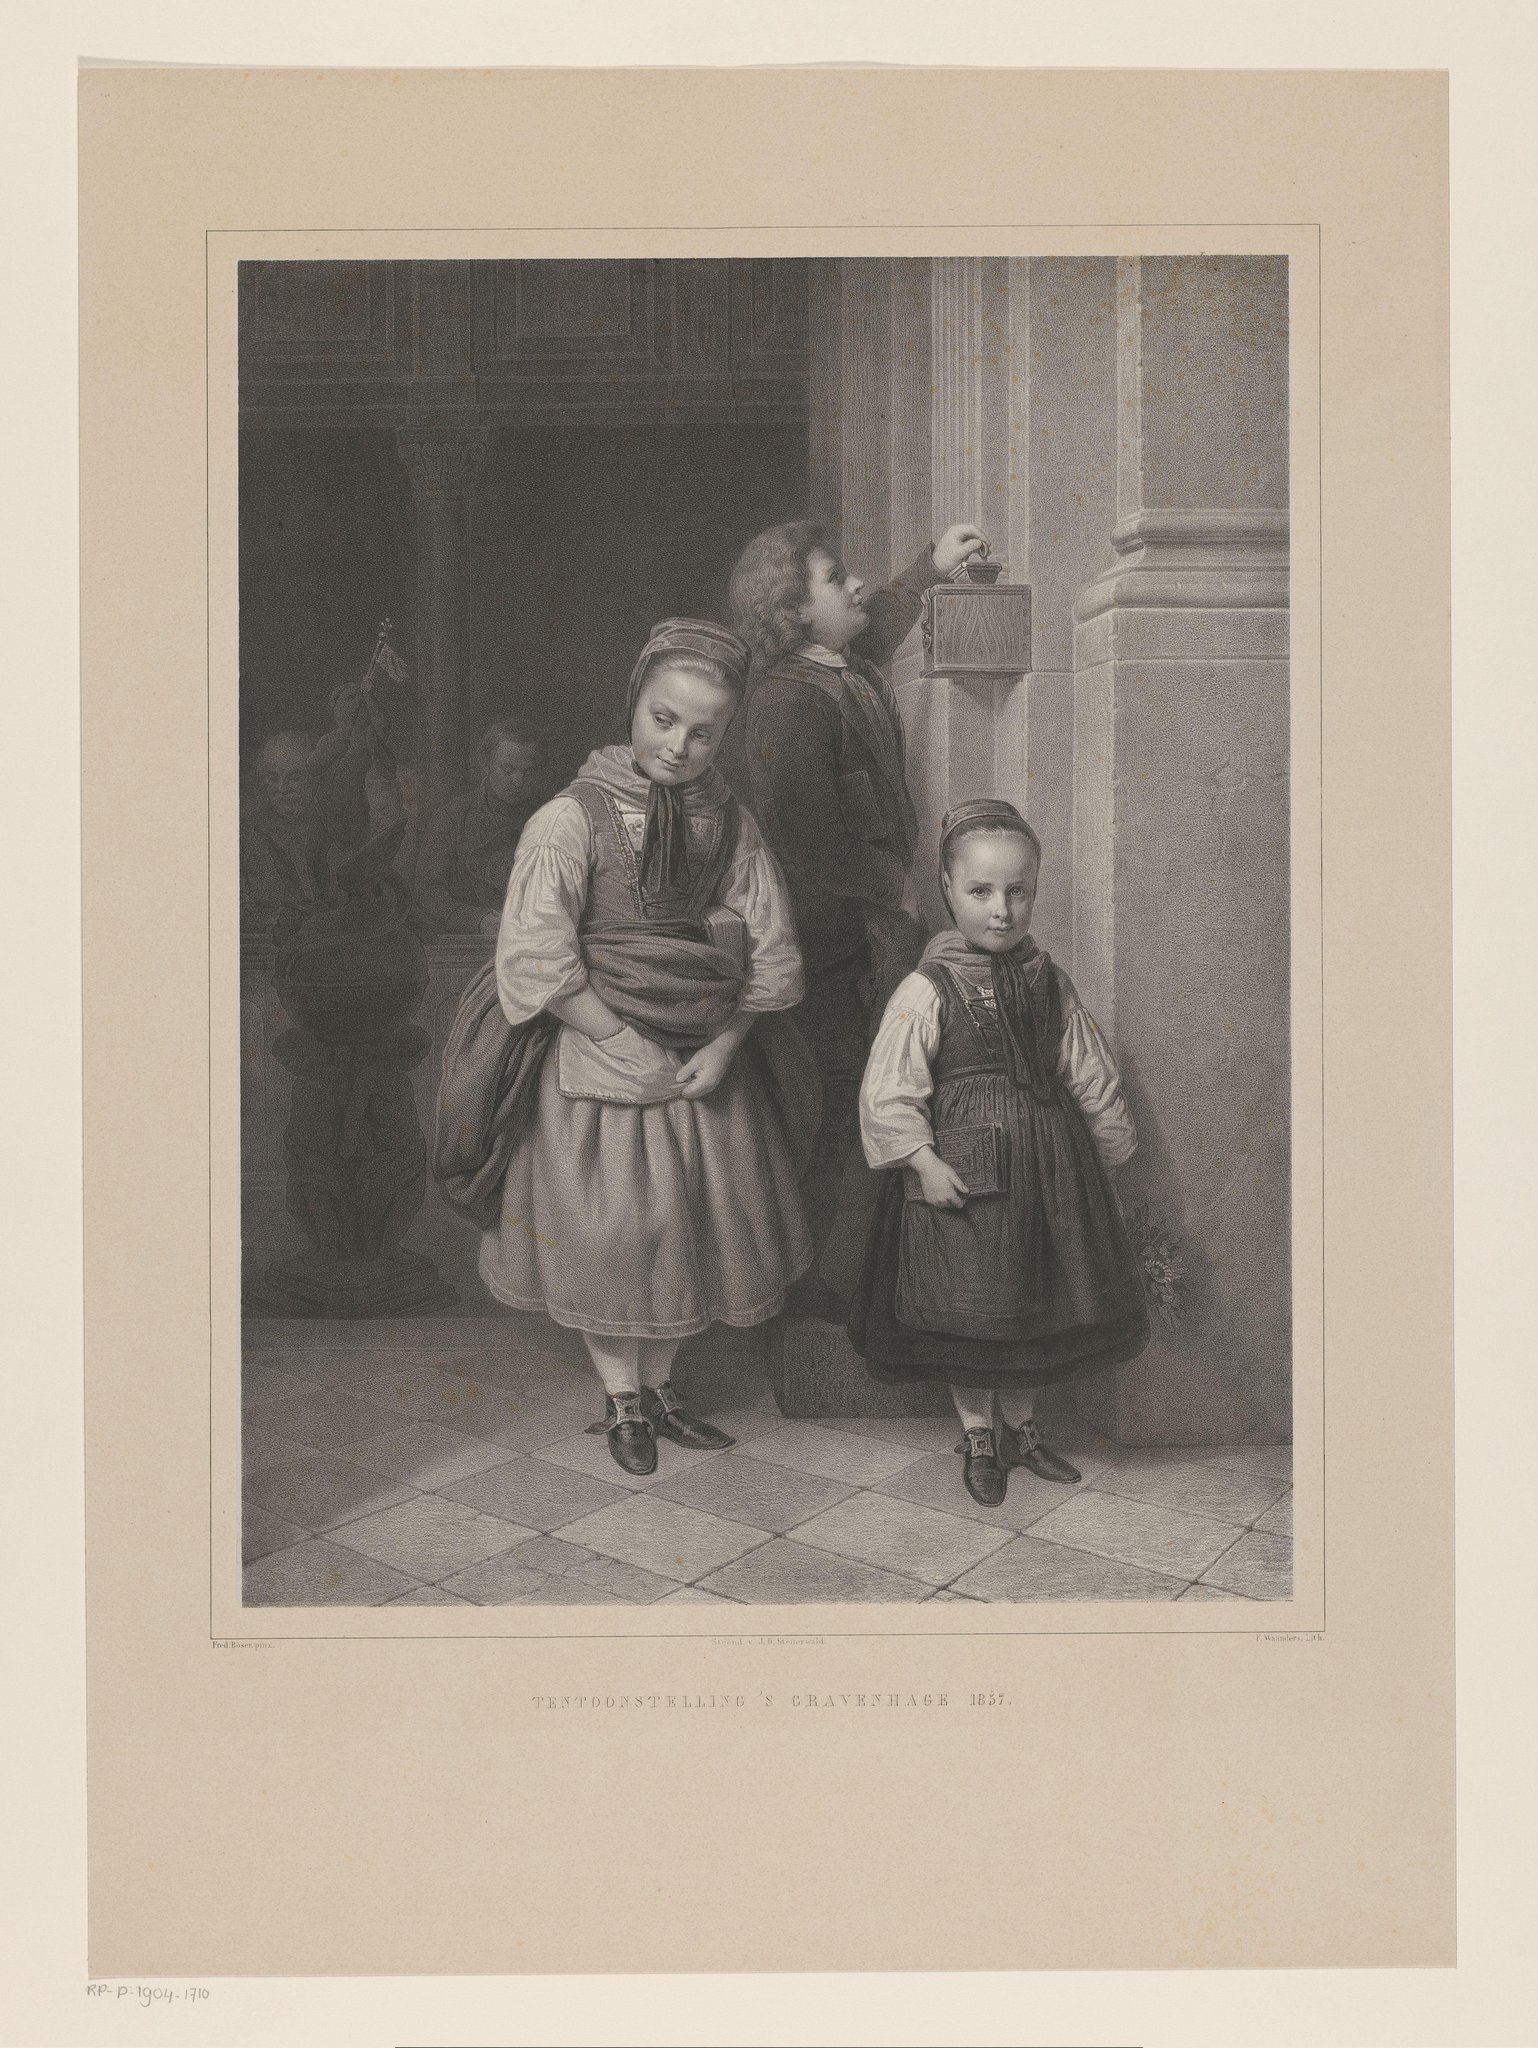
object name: print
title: Meisjes en jongen bij offerbus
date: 1857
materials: paper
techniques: lithograph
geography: the hague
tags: offertory-box, offertory-bag, child, interior of church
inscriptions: collector's mark: Lugt 2228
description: Twee meisjes en een jongen staan in een kerk voor een offerbus. De jongen gooit een munt in de bus. Links zitten twee mannen in een kerkbank.